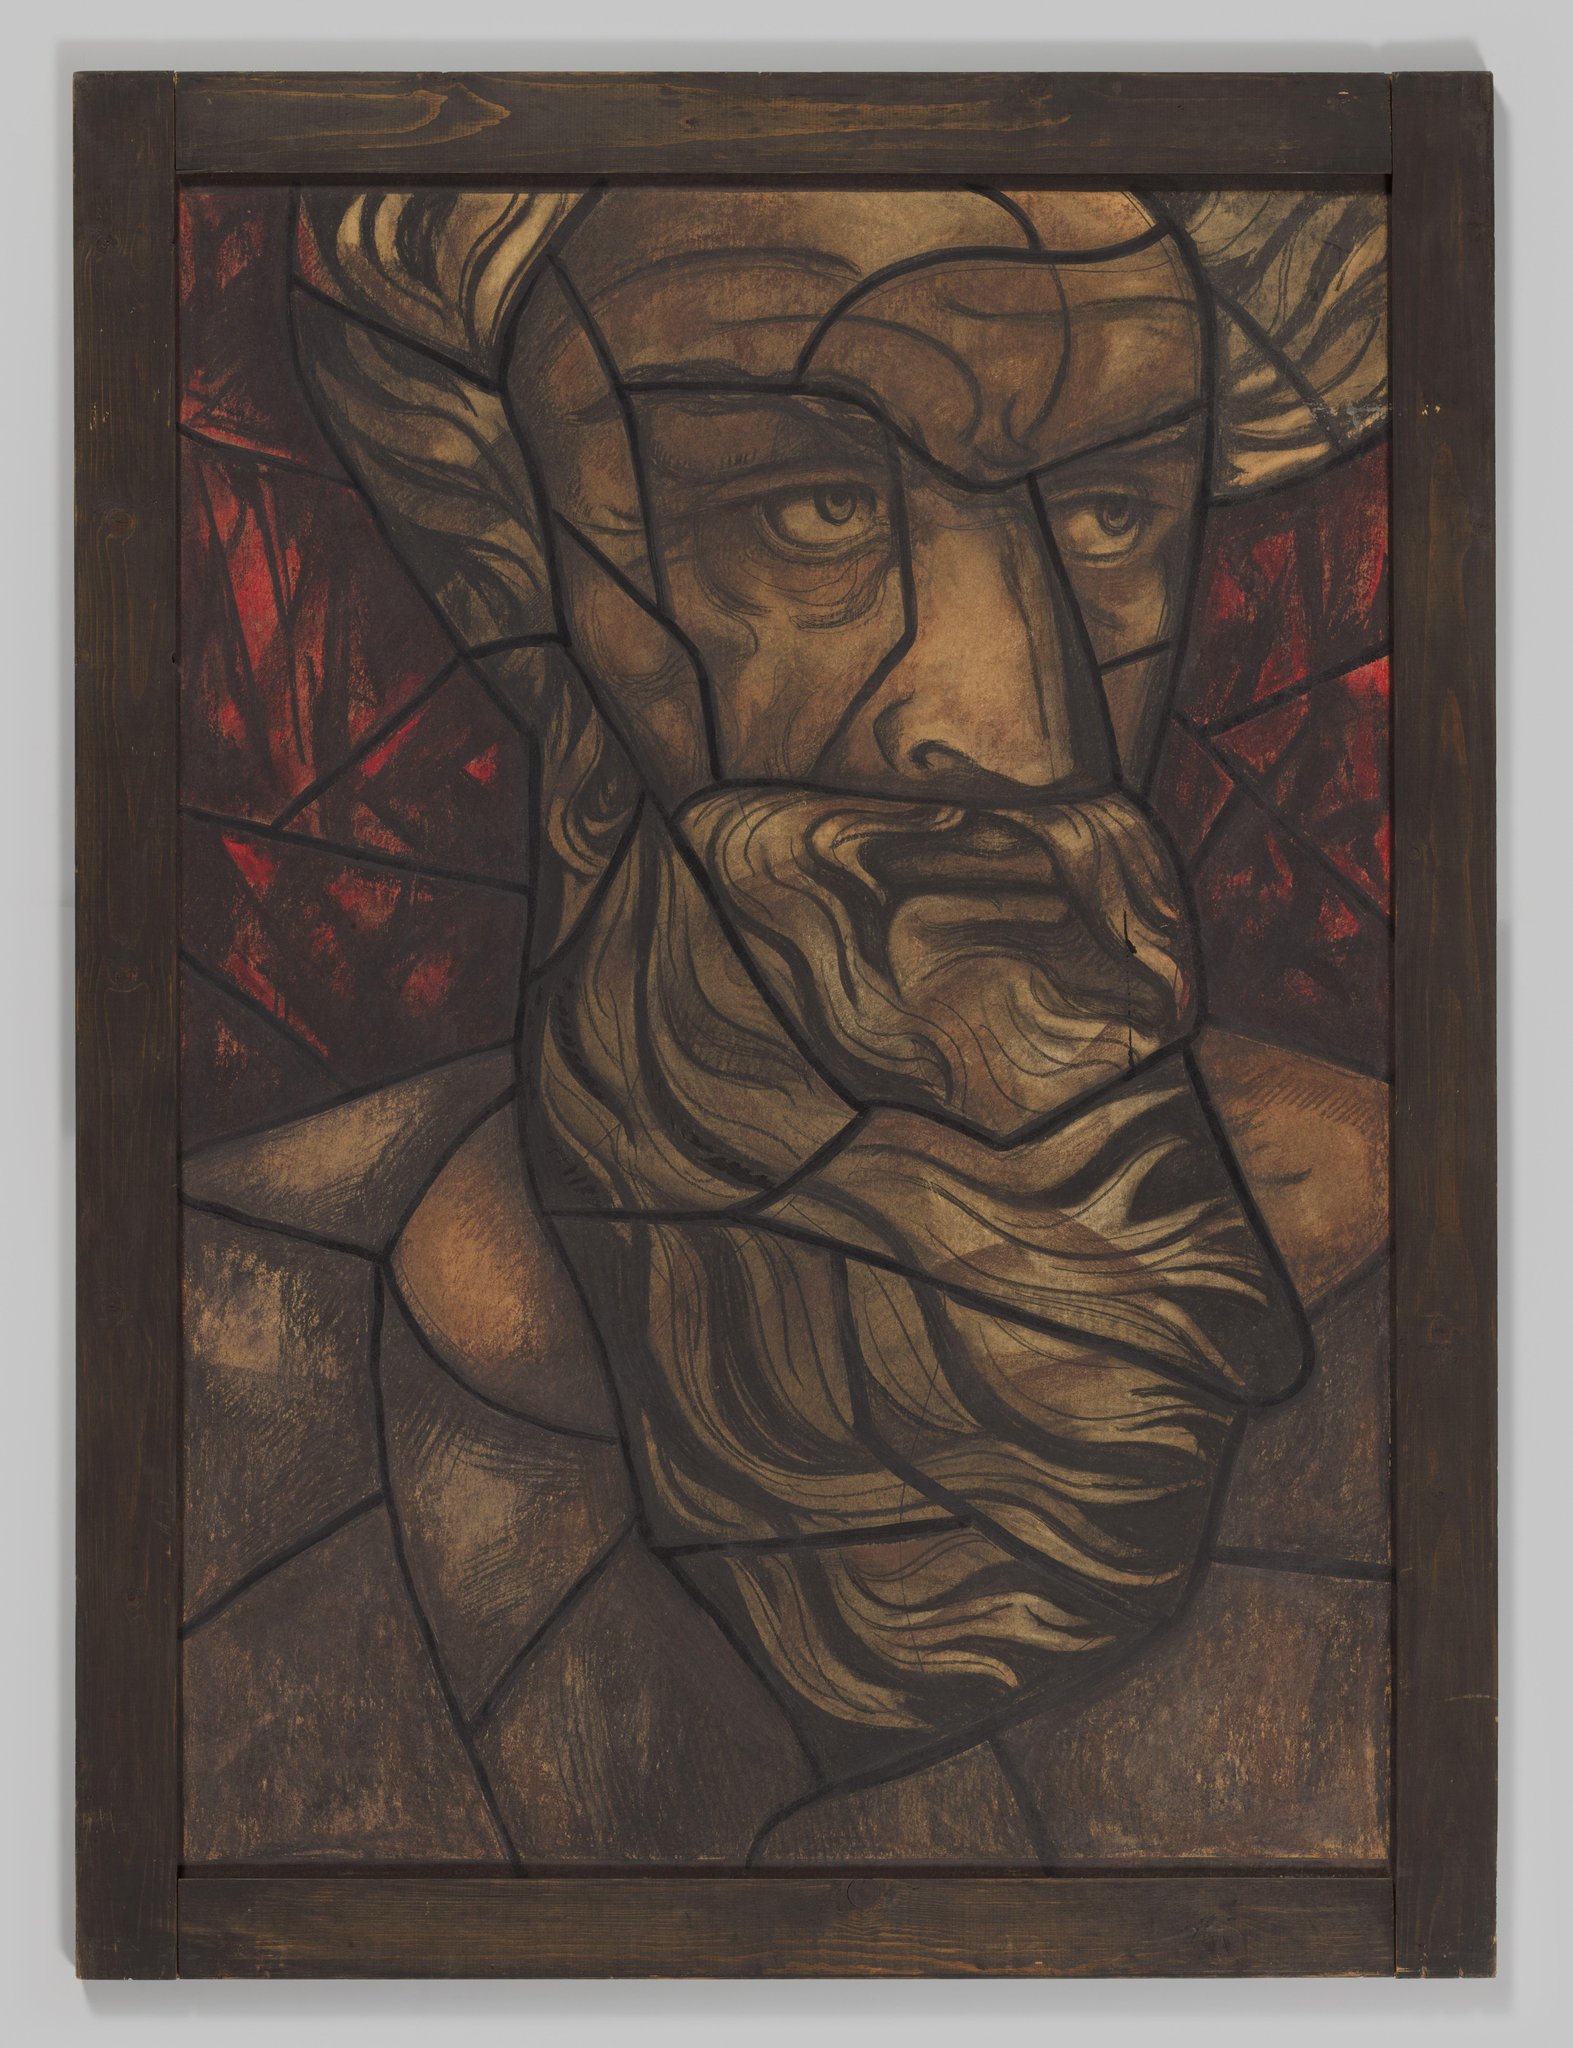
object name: drawing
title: Ontwerp voor raam in het Noordertransept in de Dom te Utrecht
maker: richard nicolaüs roland holst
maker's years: 1868-1938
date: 1878-1938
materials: cardboard, chalk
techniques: brush